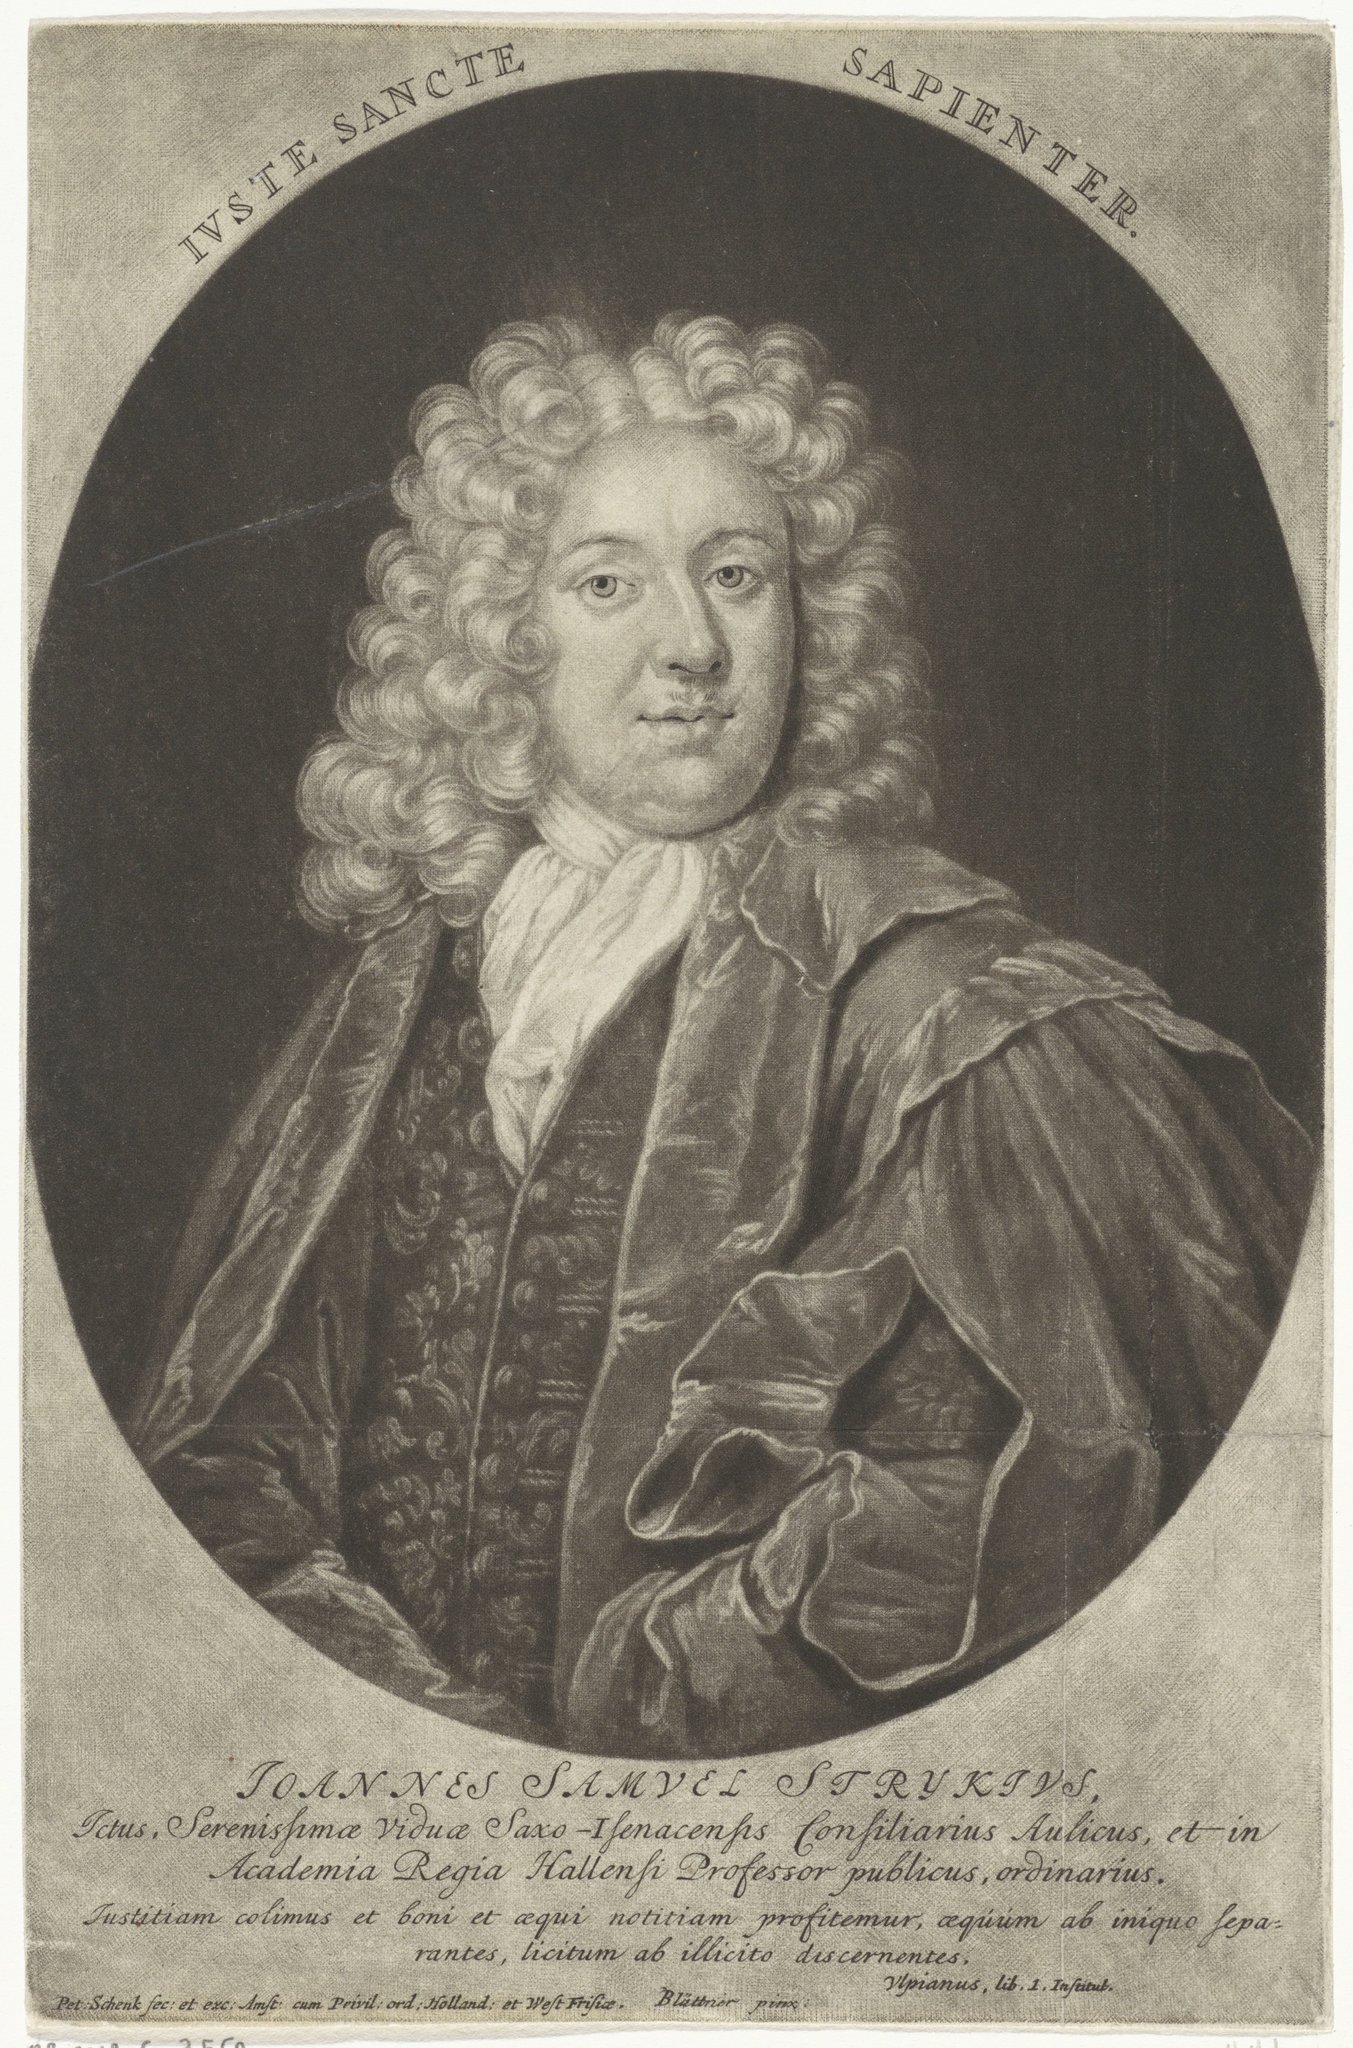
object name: print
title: Portret van Johann Samuel Stryk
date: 1670-1713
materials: paper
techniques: engraving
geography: amsterdam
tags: wig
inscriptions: collector's mark: Lugt 2228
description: De Duitse jurist en professor in de rechten Johann Samuel Stryk. Hij draagt een vest en een pruik.